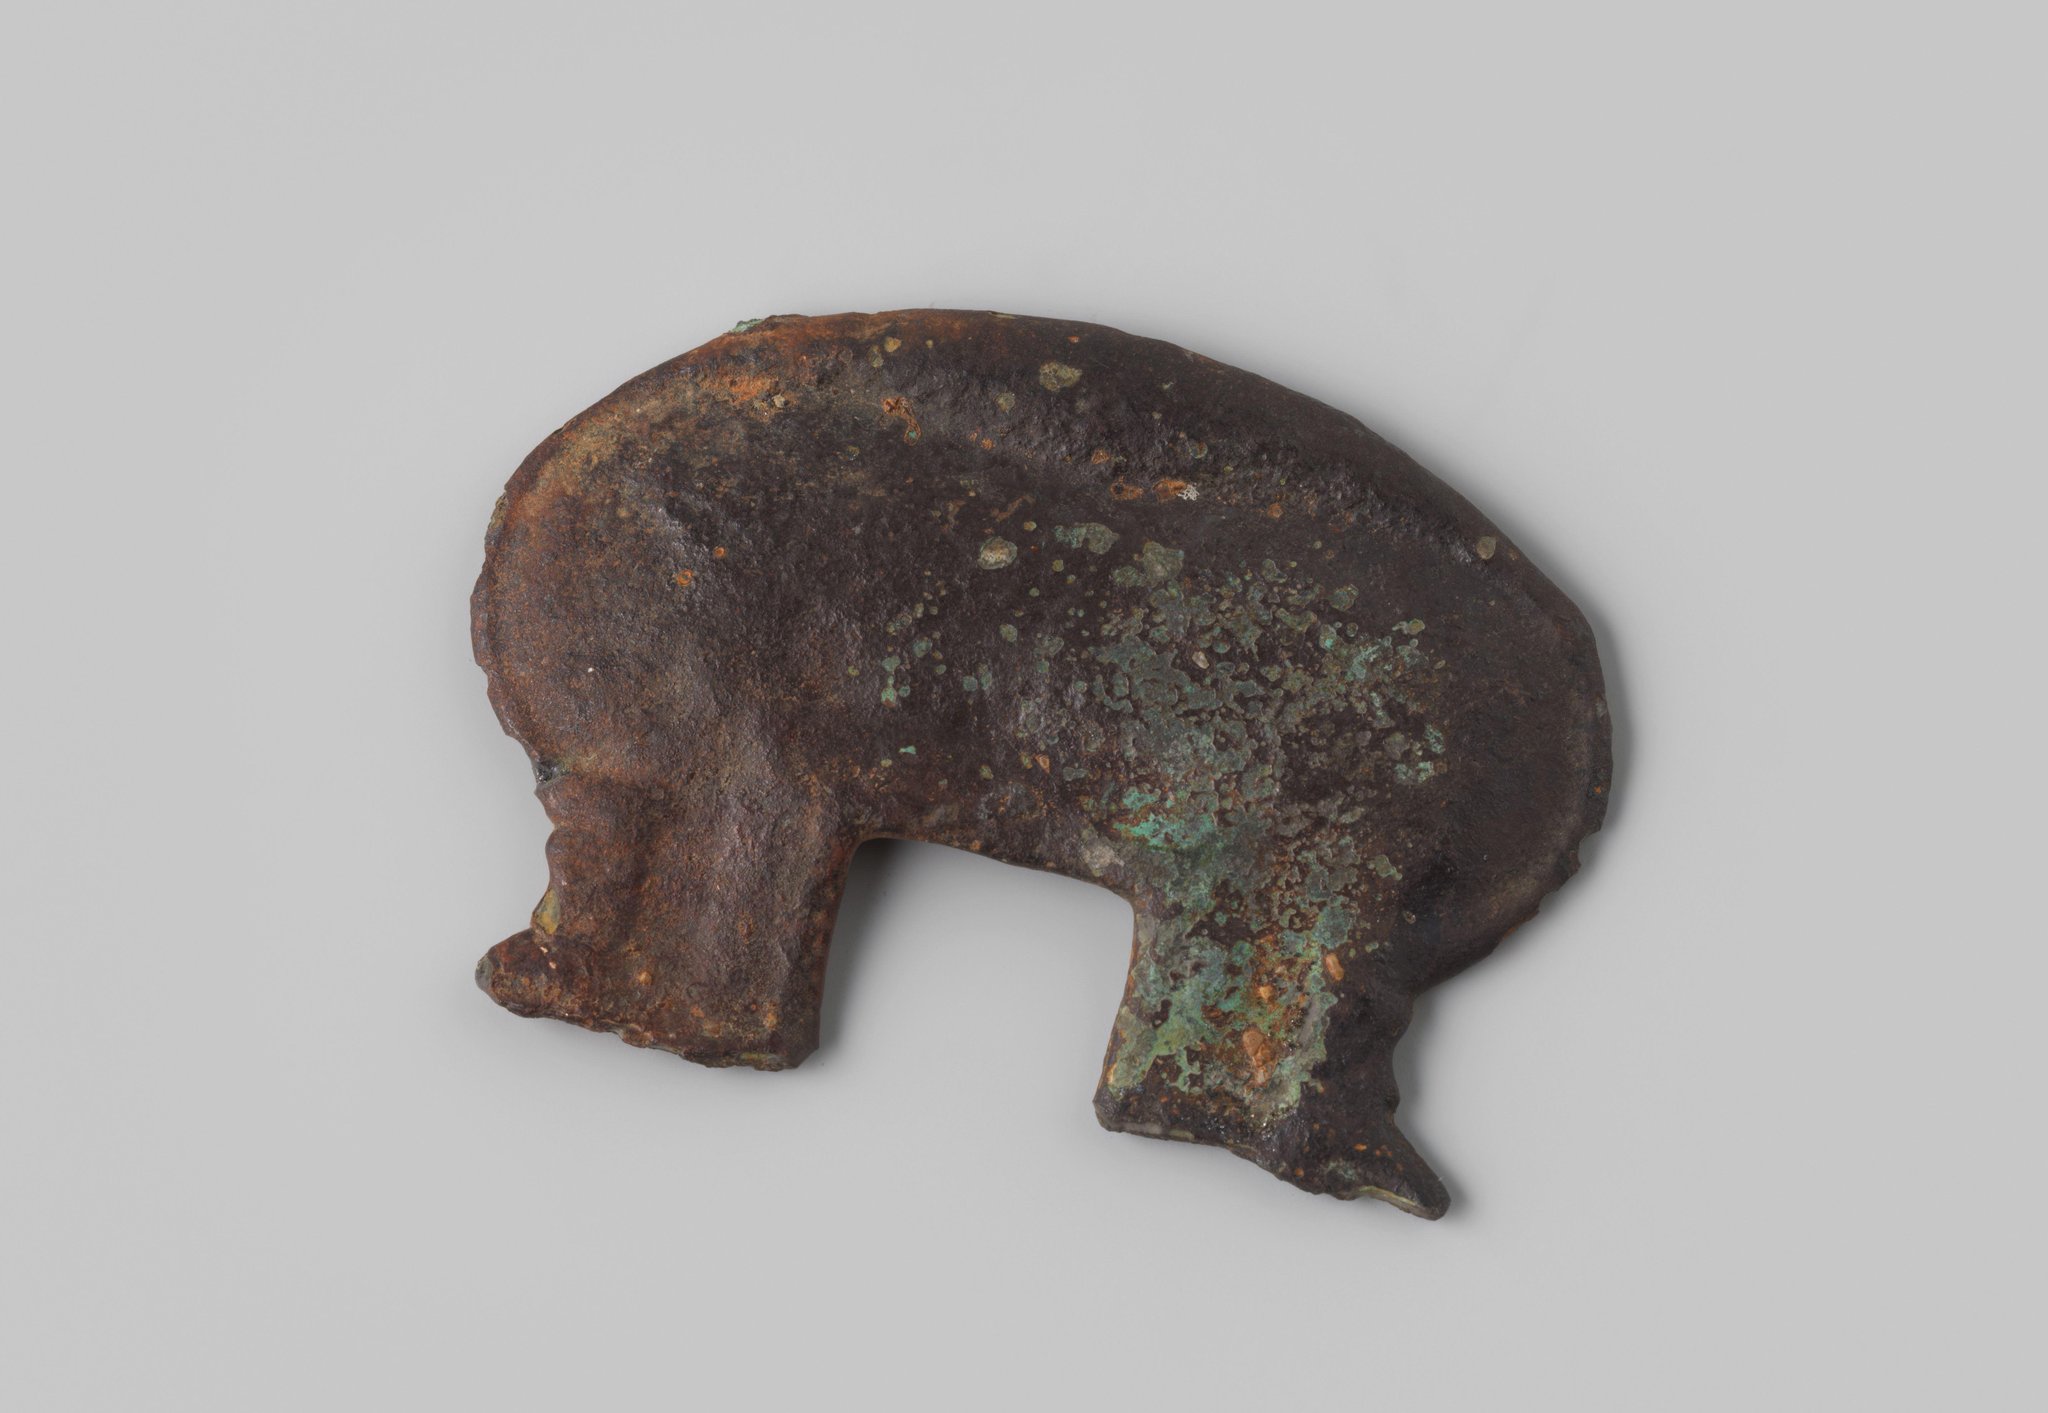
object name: beugel gevestl, gevestbeugel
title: Beugel van gevest uit het wrak van de Oost-Indiëvaarder Hollandia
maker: Anonymous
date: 1700-1743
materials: silver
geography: netherlands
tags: verenigde oostindische compagnie, hollandia (schip), annet